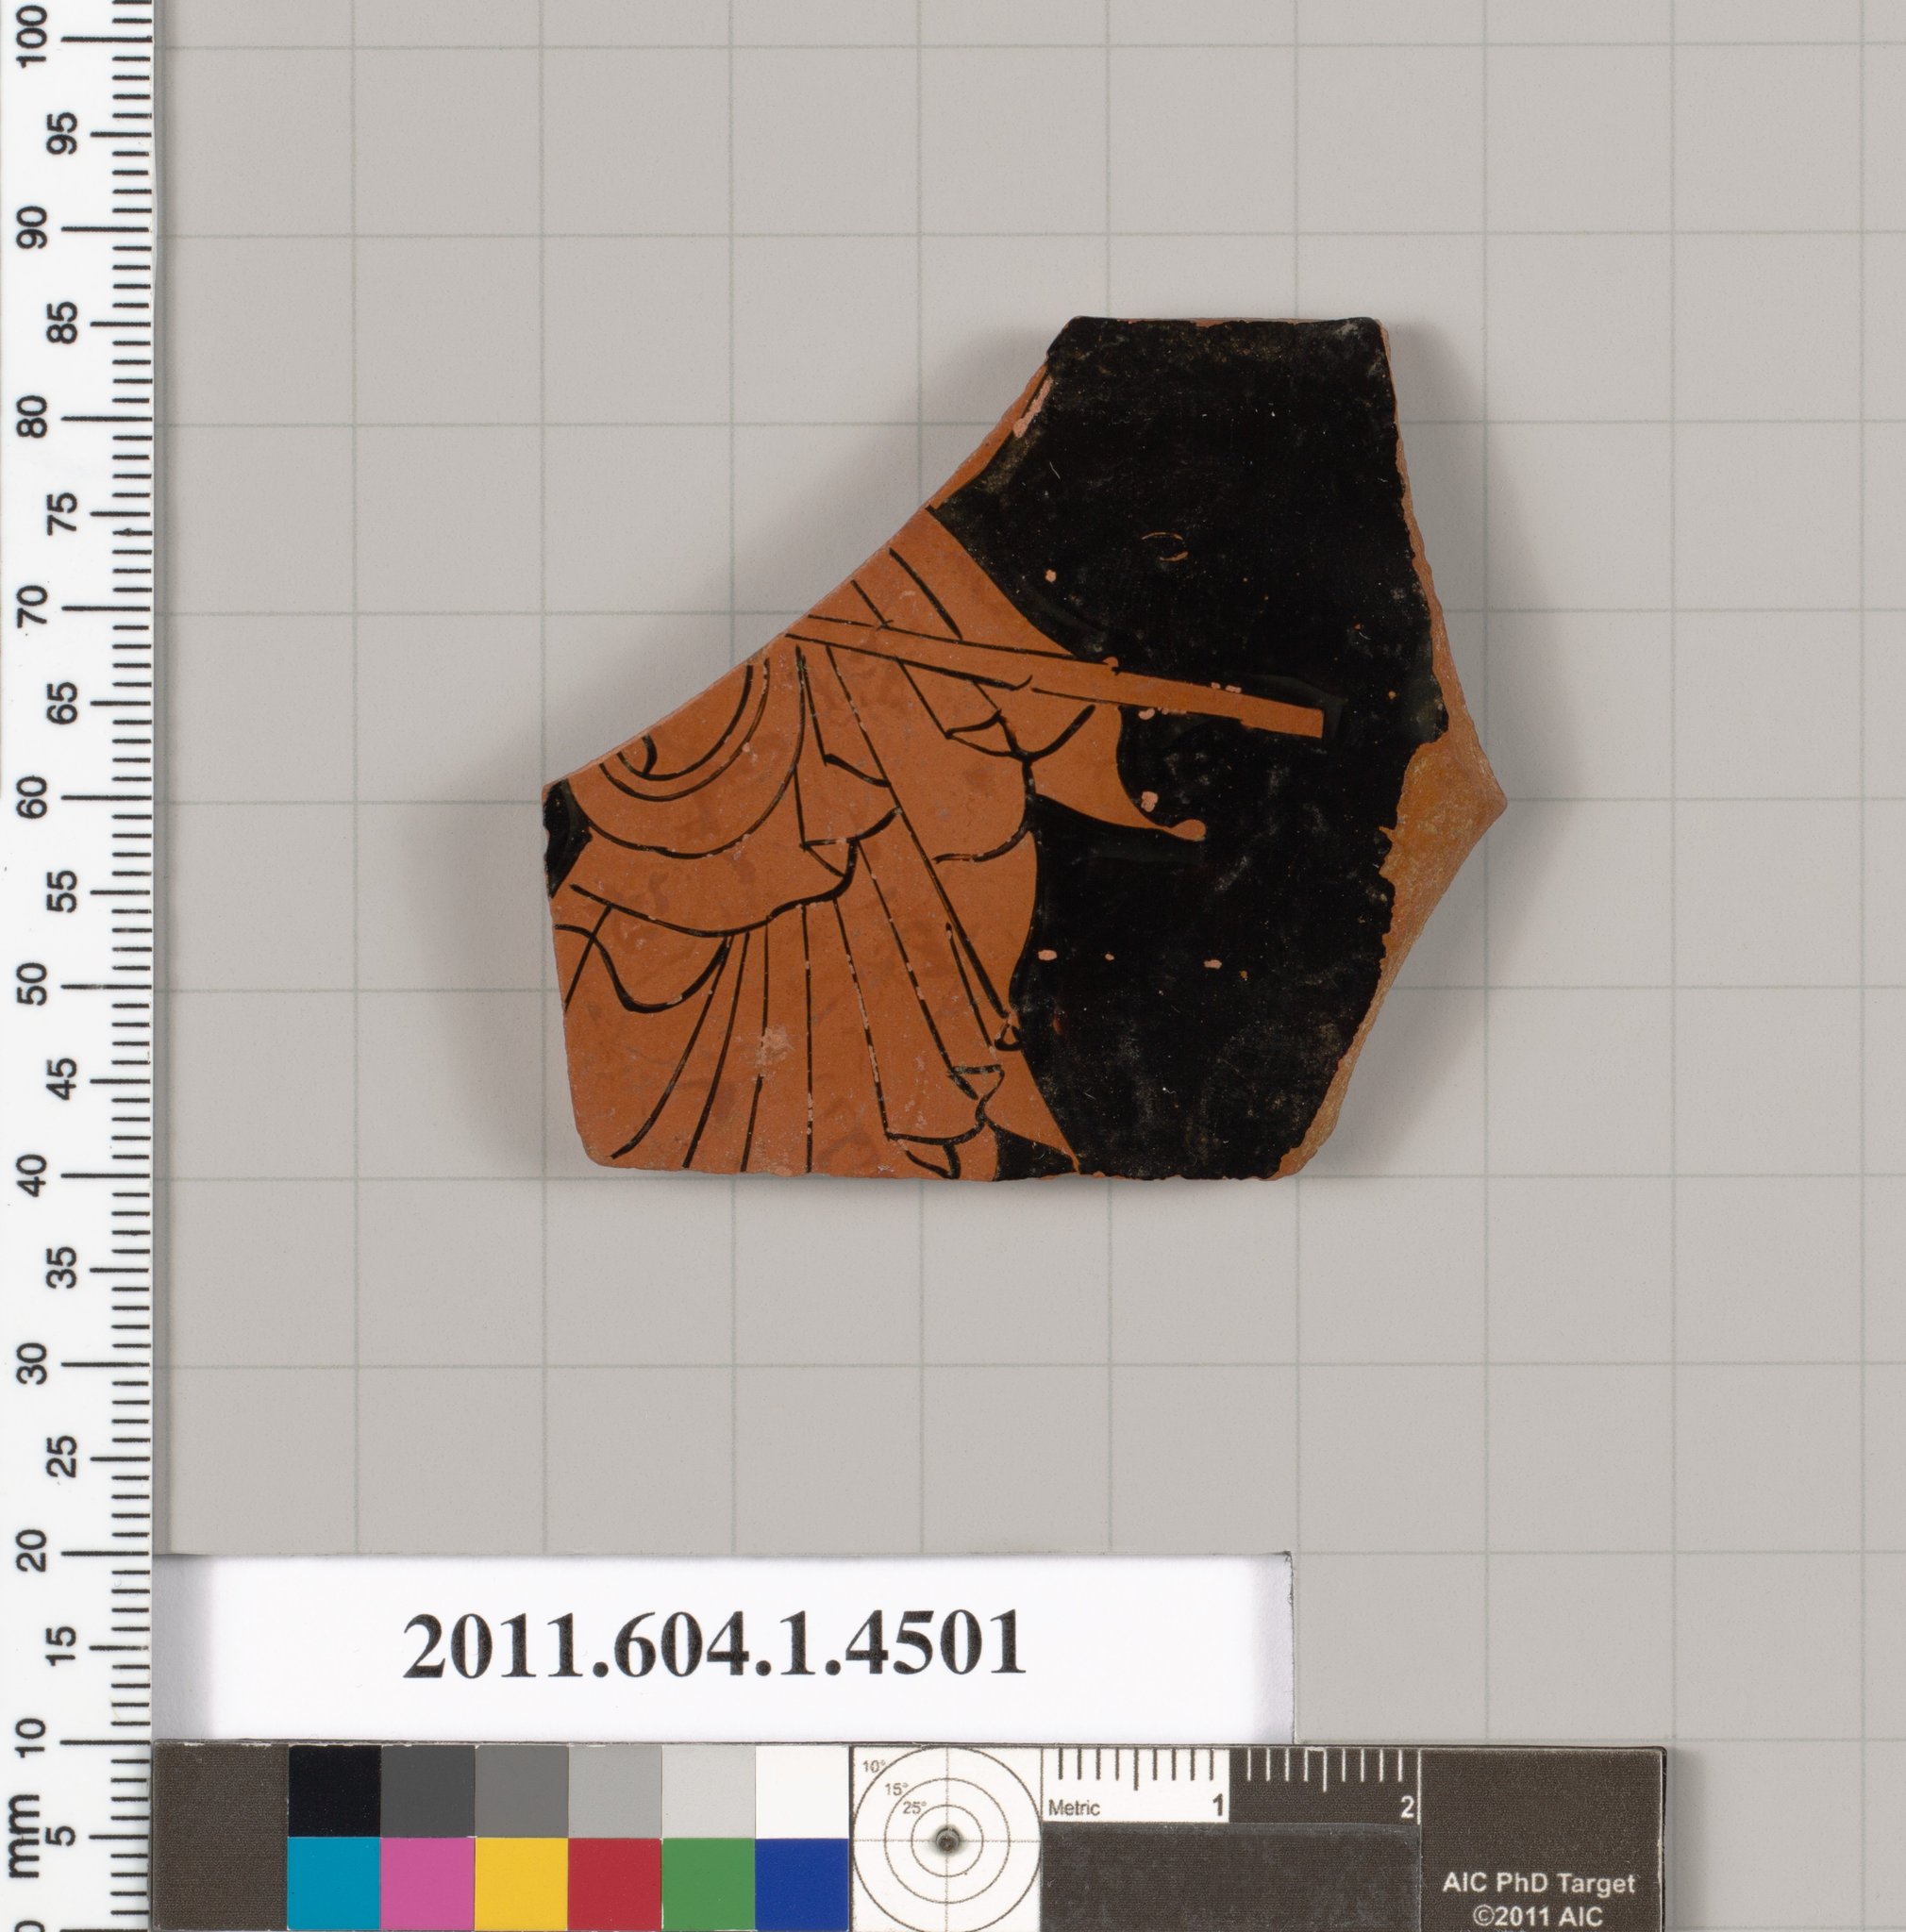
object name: kylix fragment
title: Terracotta fragment of a kylix (drinking cup)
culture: greek, attic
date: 500-480 BCE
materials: terracotta